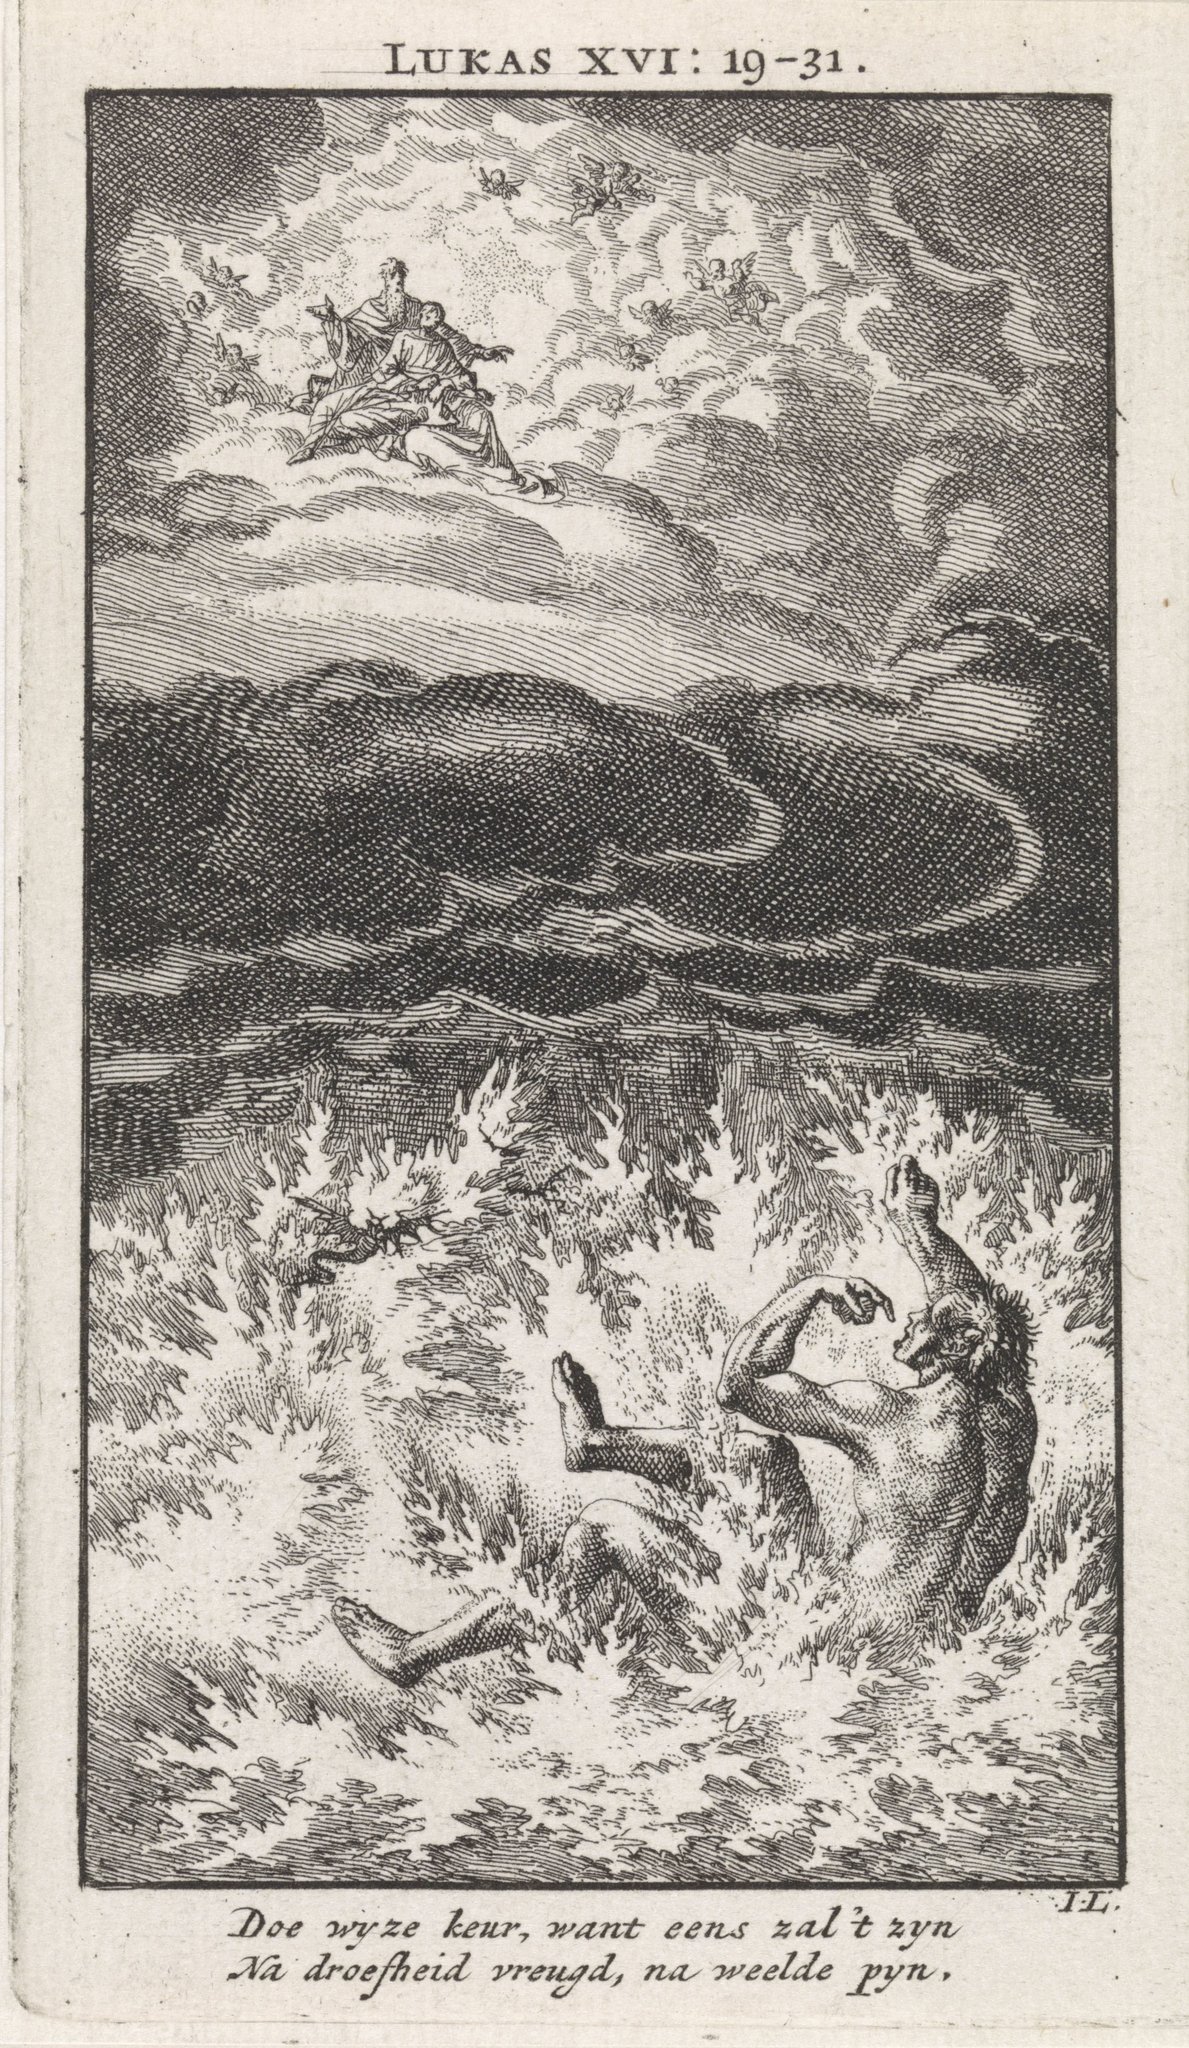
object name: print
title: Lazarus in Abrahams schoot en de rijke man in de hel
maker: jan luyken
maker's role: draughtsman, print maker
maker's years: 1649-1712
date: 1712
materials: paper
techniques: etching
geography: amsterdam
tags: the rich man (dives) is feasting, while poor lazarus is starving at the gate (dogs licking lazarus' sores) (luke 16:19-31)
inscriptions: collector's mark: Lugt 2228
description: Illustratie voor: Luyken, Jan. Bybel printen. Amsterdam: Pieter Arentsz. II (wed.) en Cornelis van der Sys, 1712, p. 28.